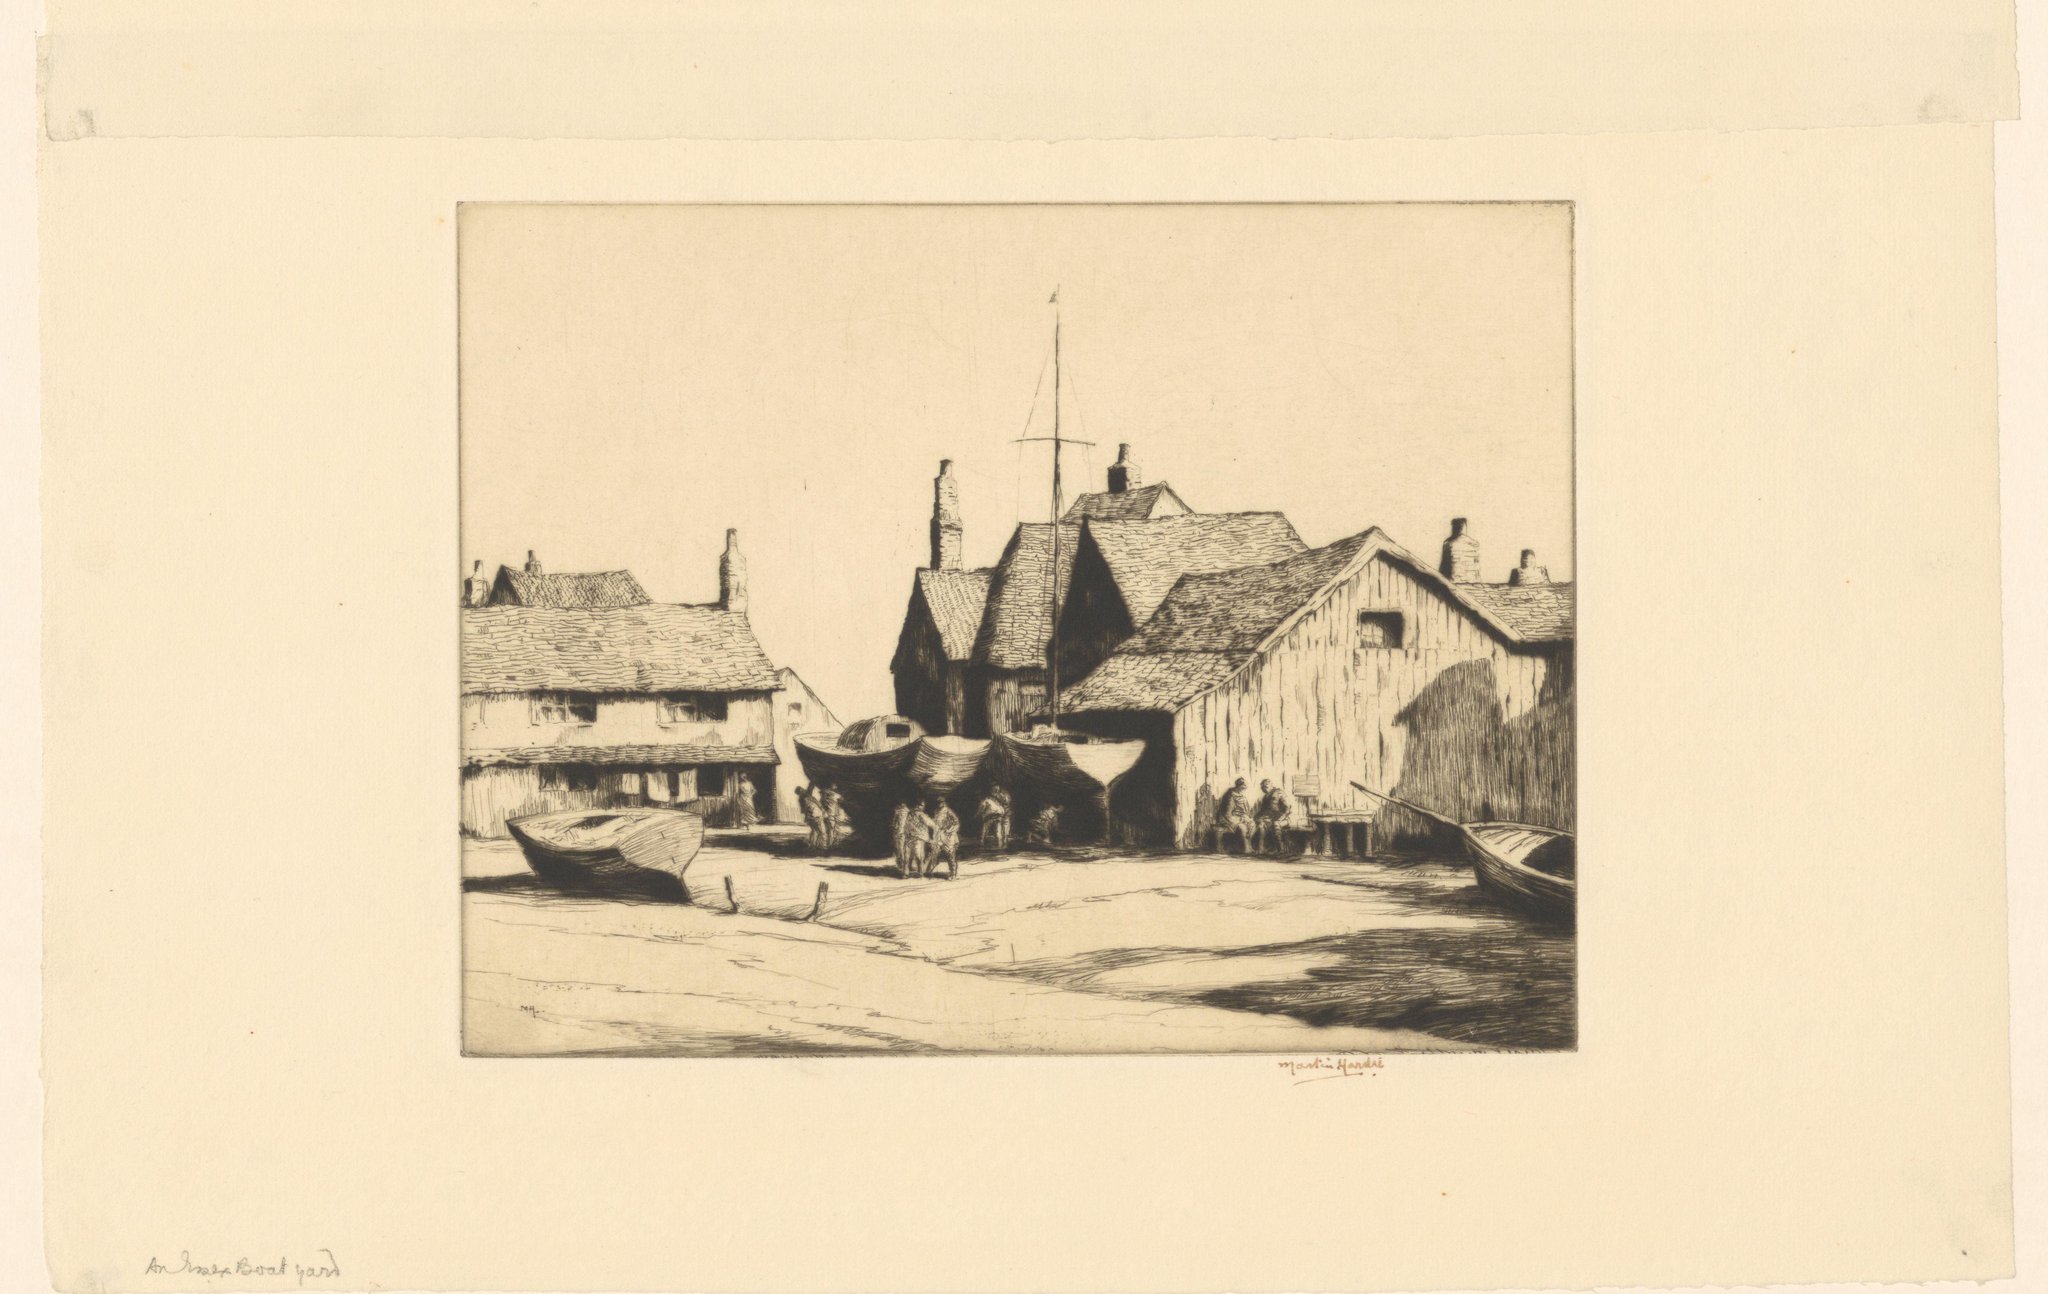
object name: print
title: Scheepswerf in West Mersea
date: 1924-1926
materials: paper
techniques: drypoint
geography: west mersea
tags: pier, quay, wharf, village (+ city(-scape) with figures, staffage)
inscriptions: collector's mark: Lugt 2760, annotation: ‘Martin Hardie’, collector's mark: Lugt 2228